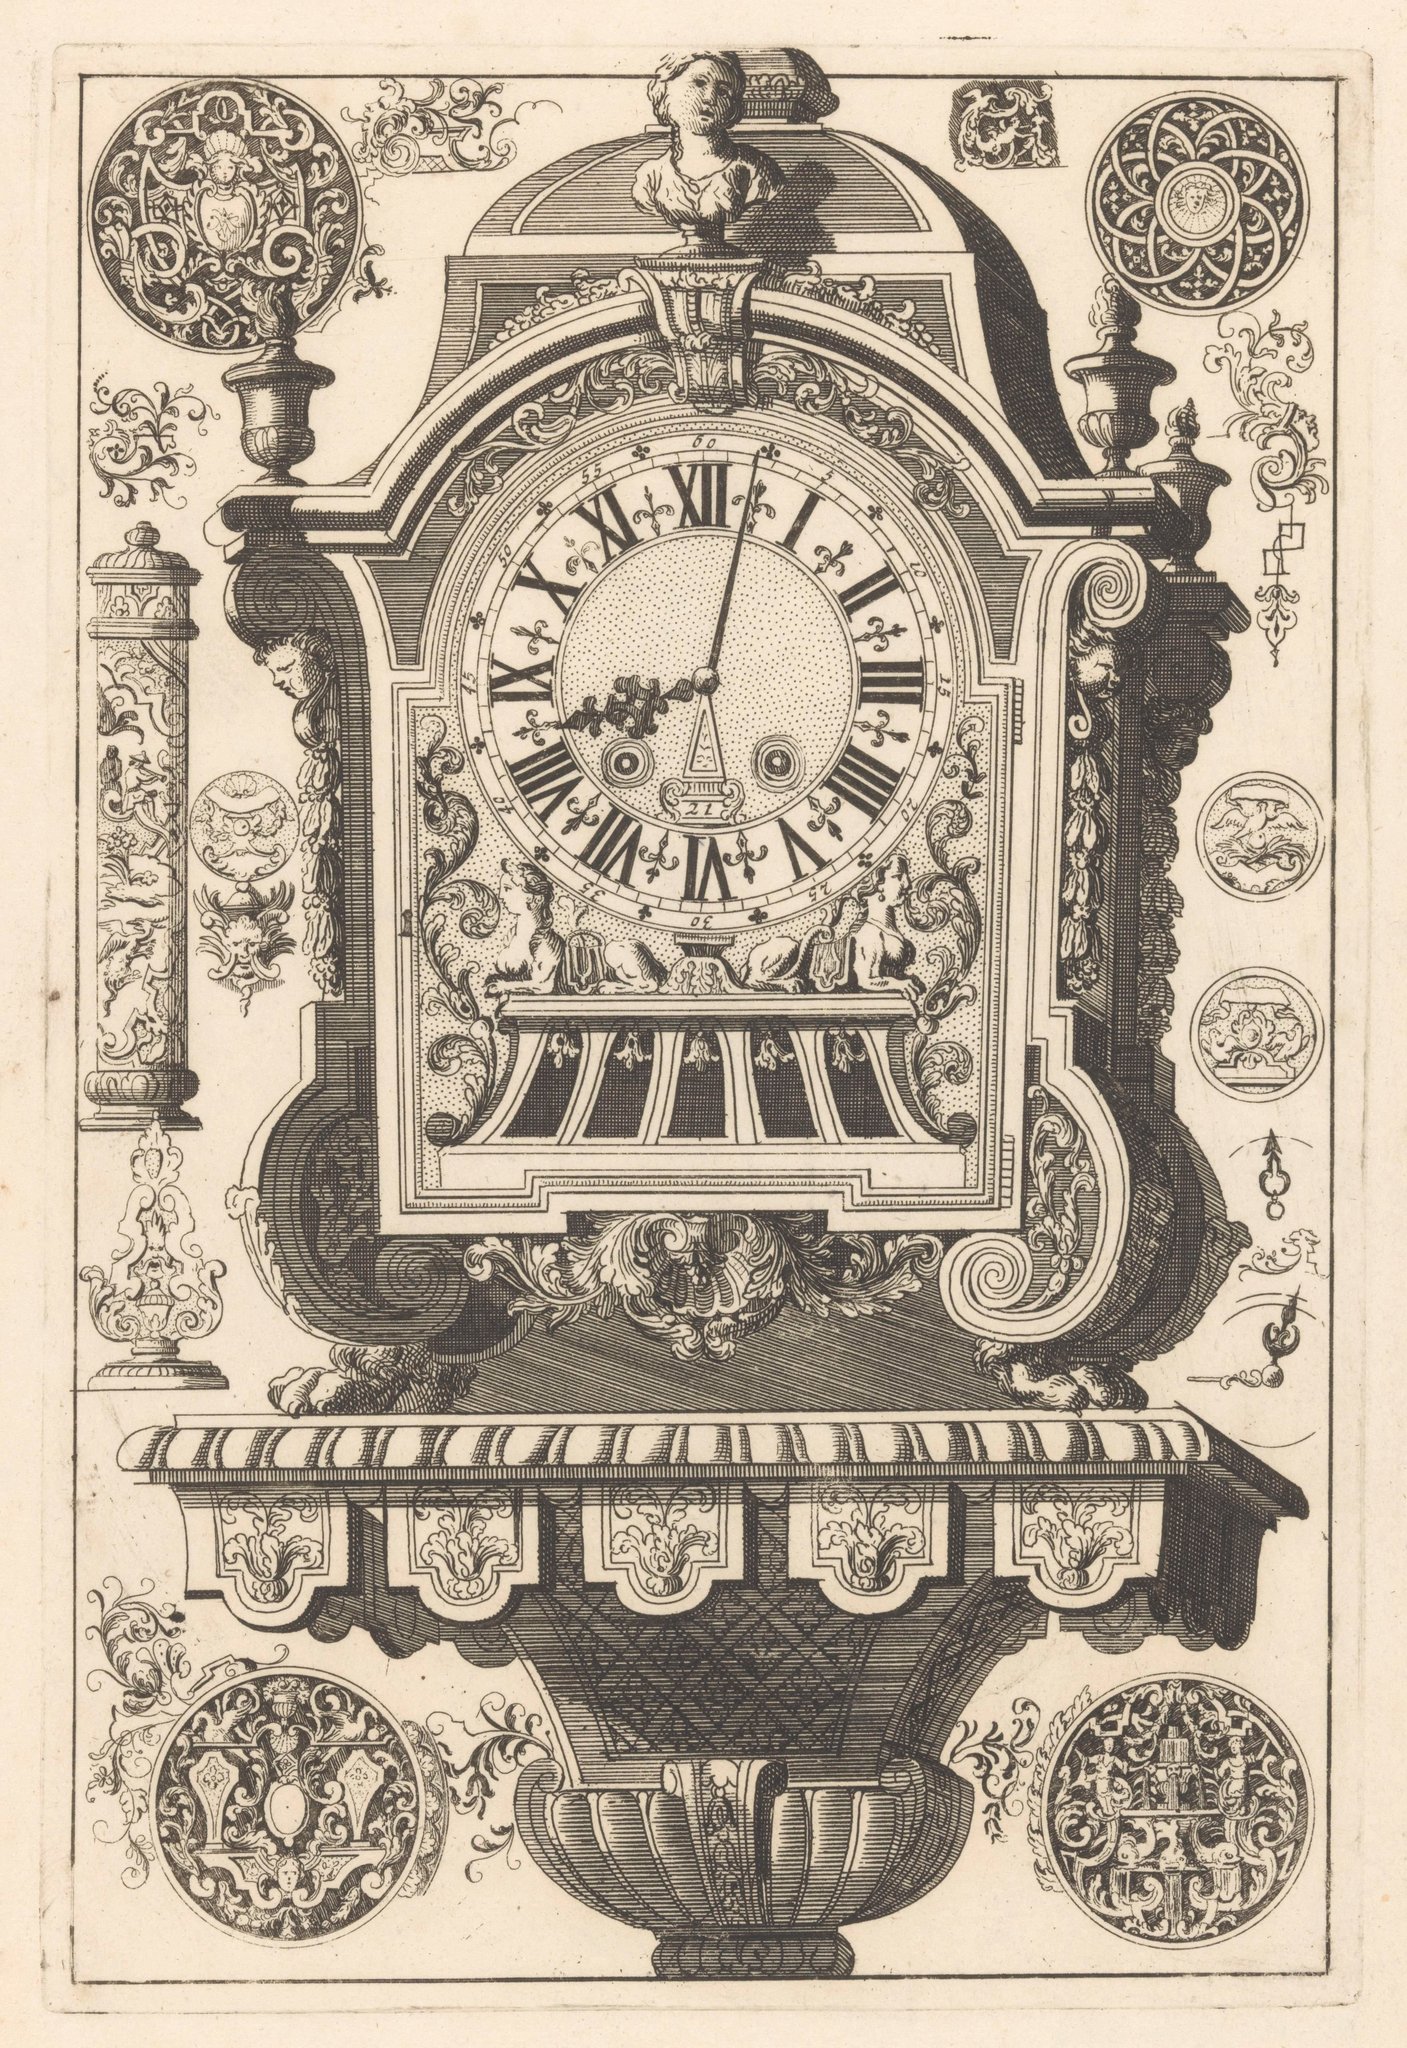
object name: ornament print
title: Pendule bekroond met buste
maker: Anonymous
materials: paper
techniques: etching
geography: netherlands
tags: clock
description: Pendule bekroond met een vrouwelijke buste. De pendule is omringd door vier decoraties voor wijzerplaten en twaalf andere motieven.